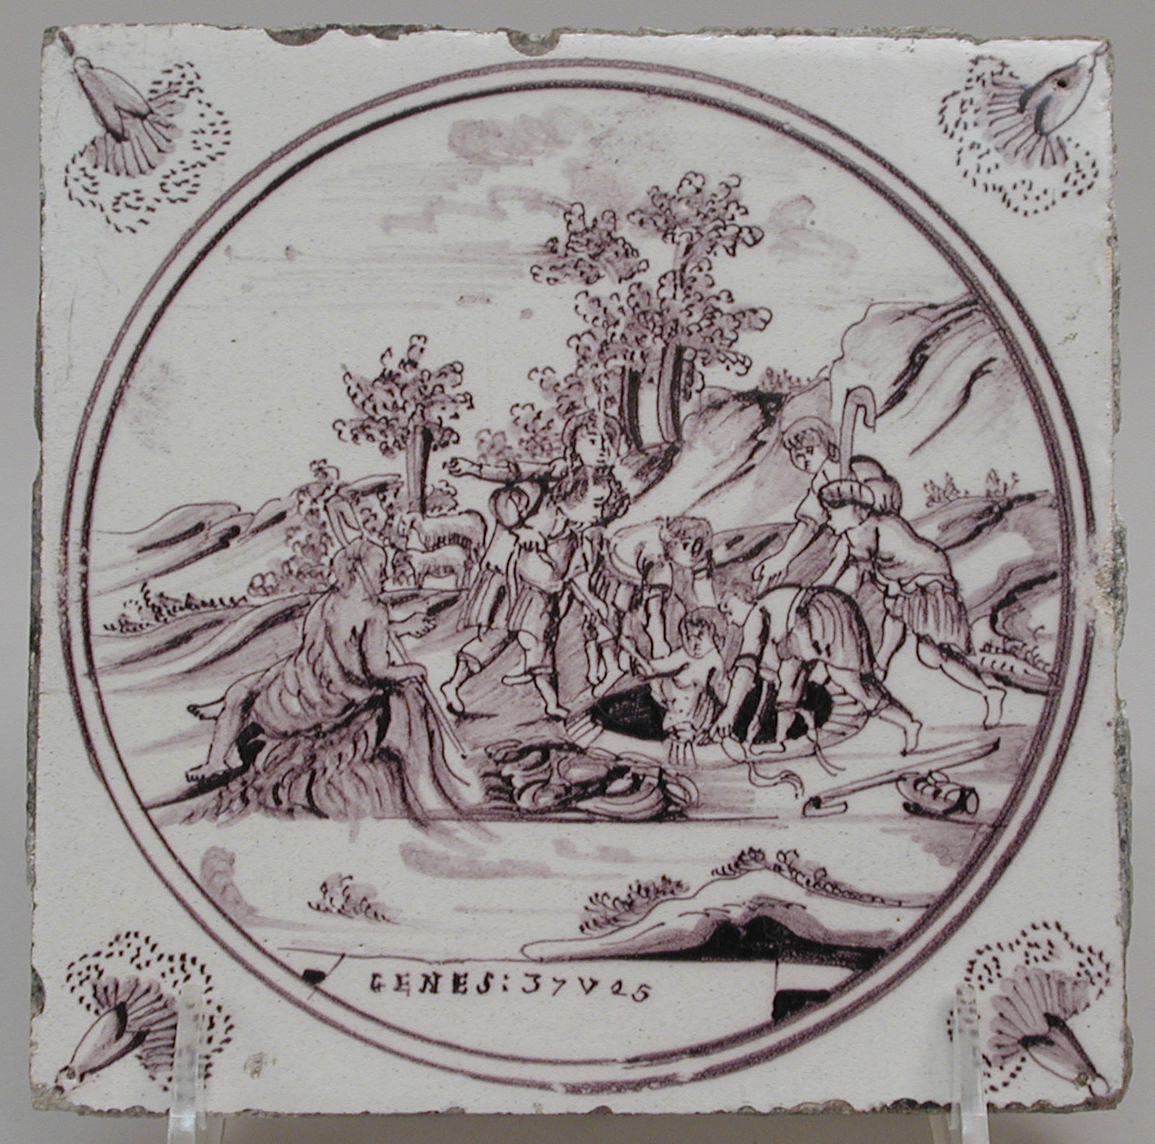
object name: tile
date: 1701-1800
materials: earthenware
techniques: glazing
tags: men,trees